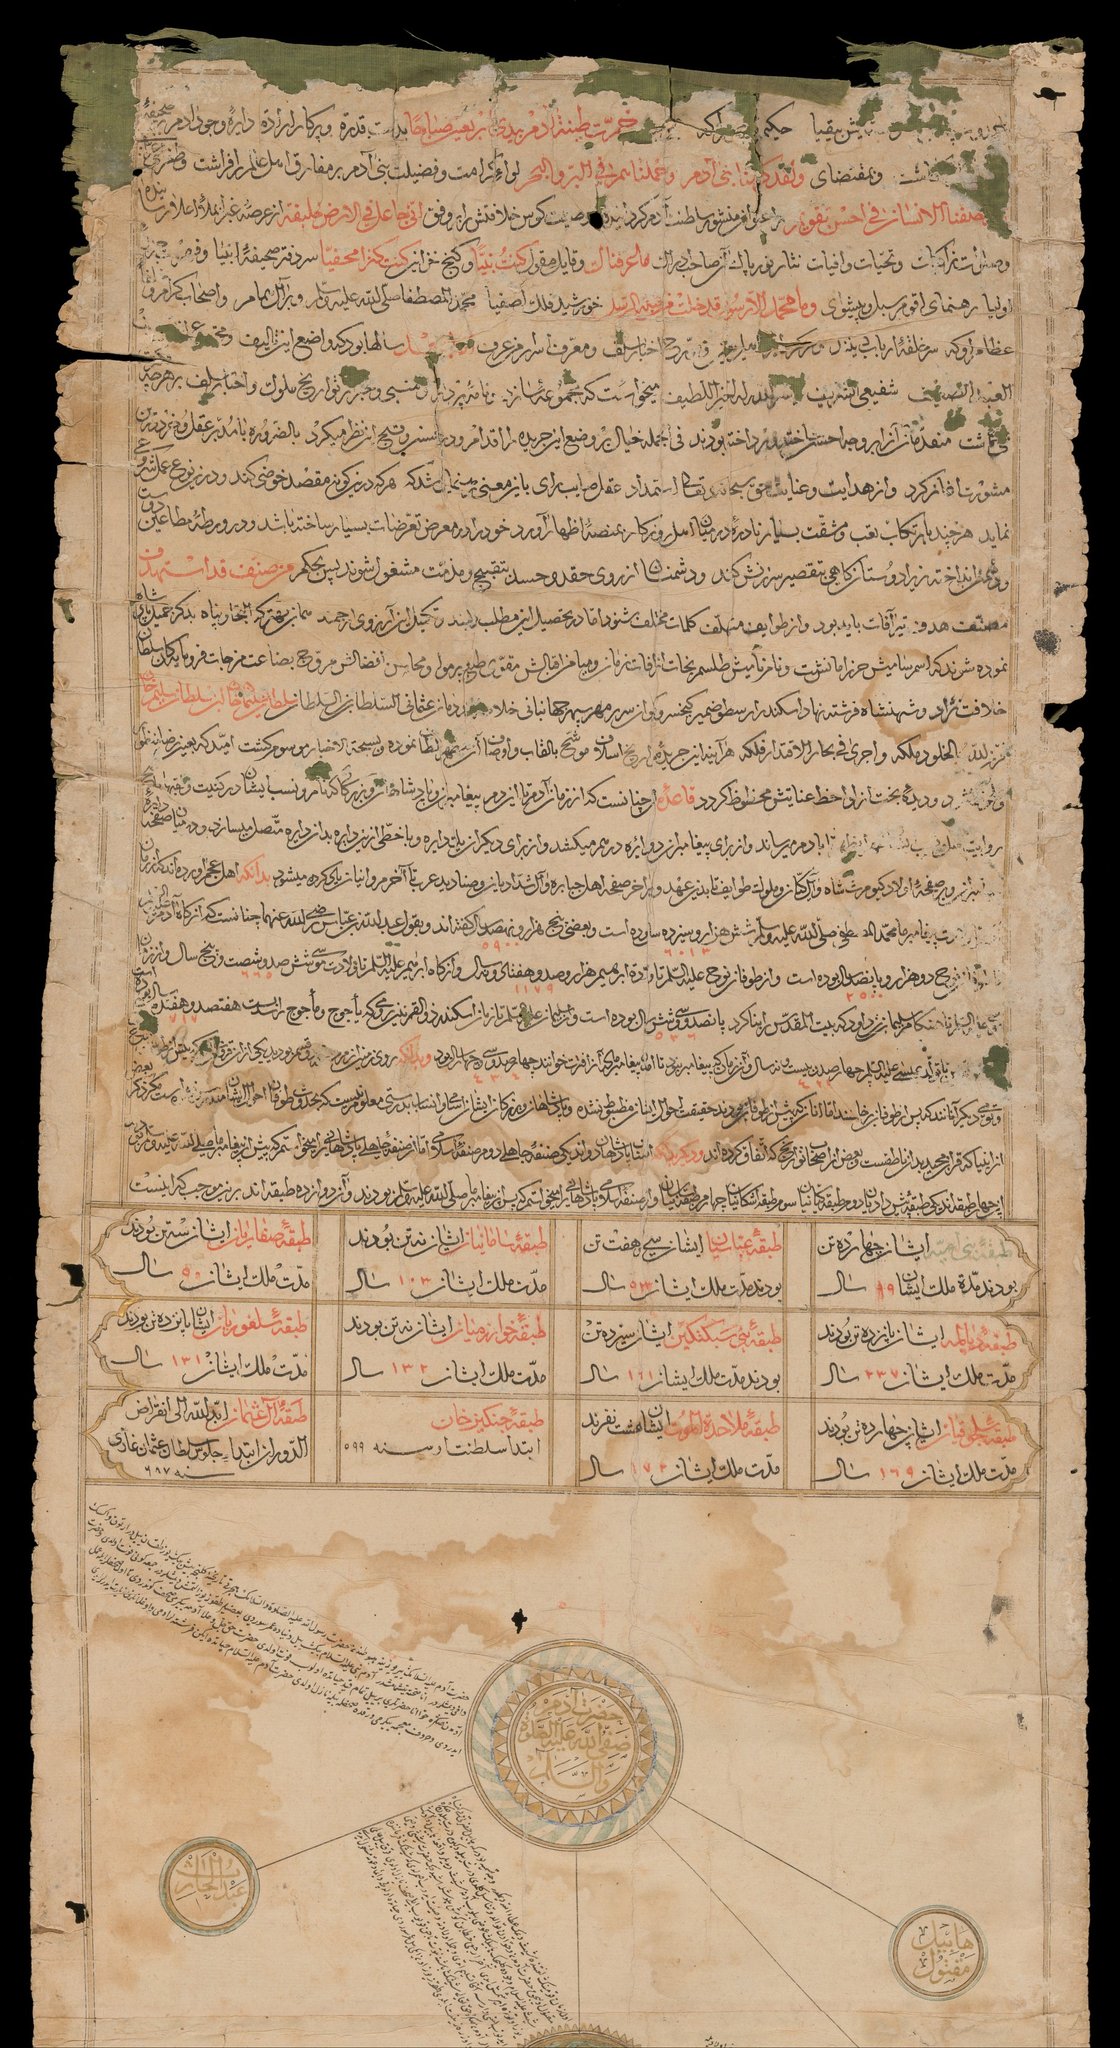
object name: scroll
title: Genealogical Scroll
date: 1601-1700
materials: gilt, ink, paper, silk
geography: turkey